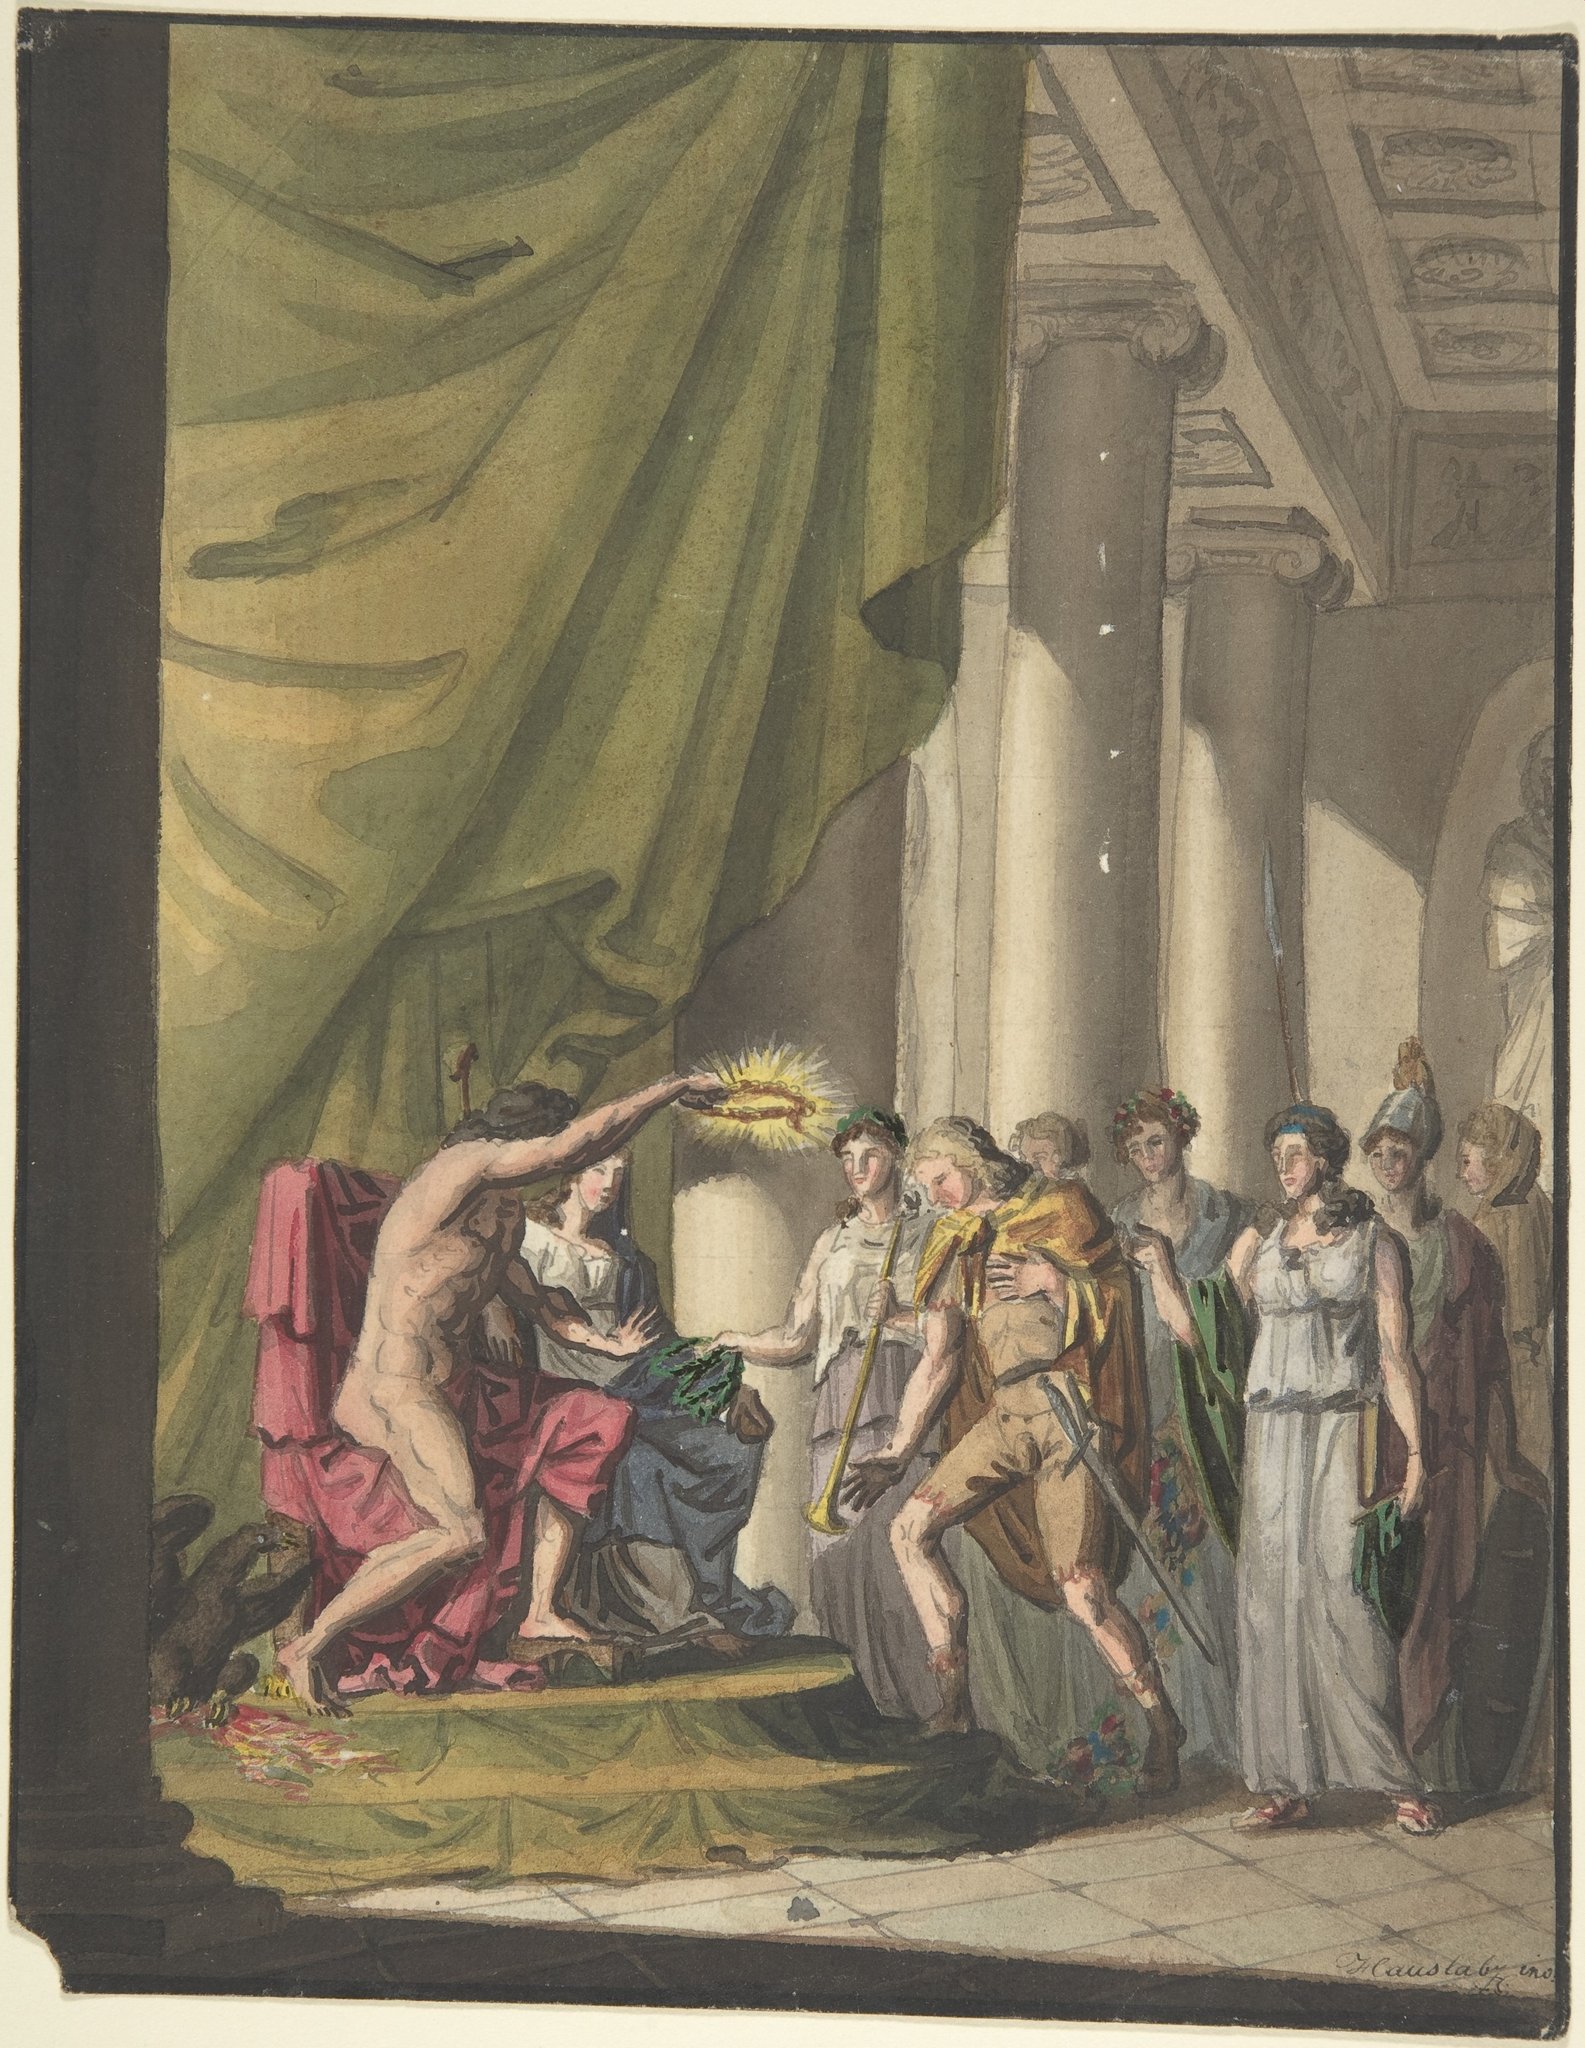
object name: drawing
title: Allegory of Victory: Soldier Being Crowned by Laurels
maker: franz von hauslab the younger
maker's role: artist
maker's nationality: austrian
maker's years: 1798-1883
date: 1814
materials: gouache, watercolor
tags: soldiers,male nudes,women